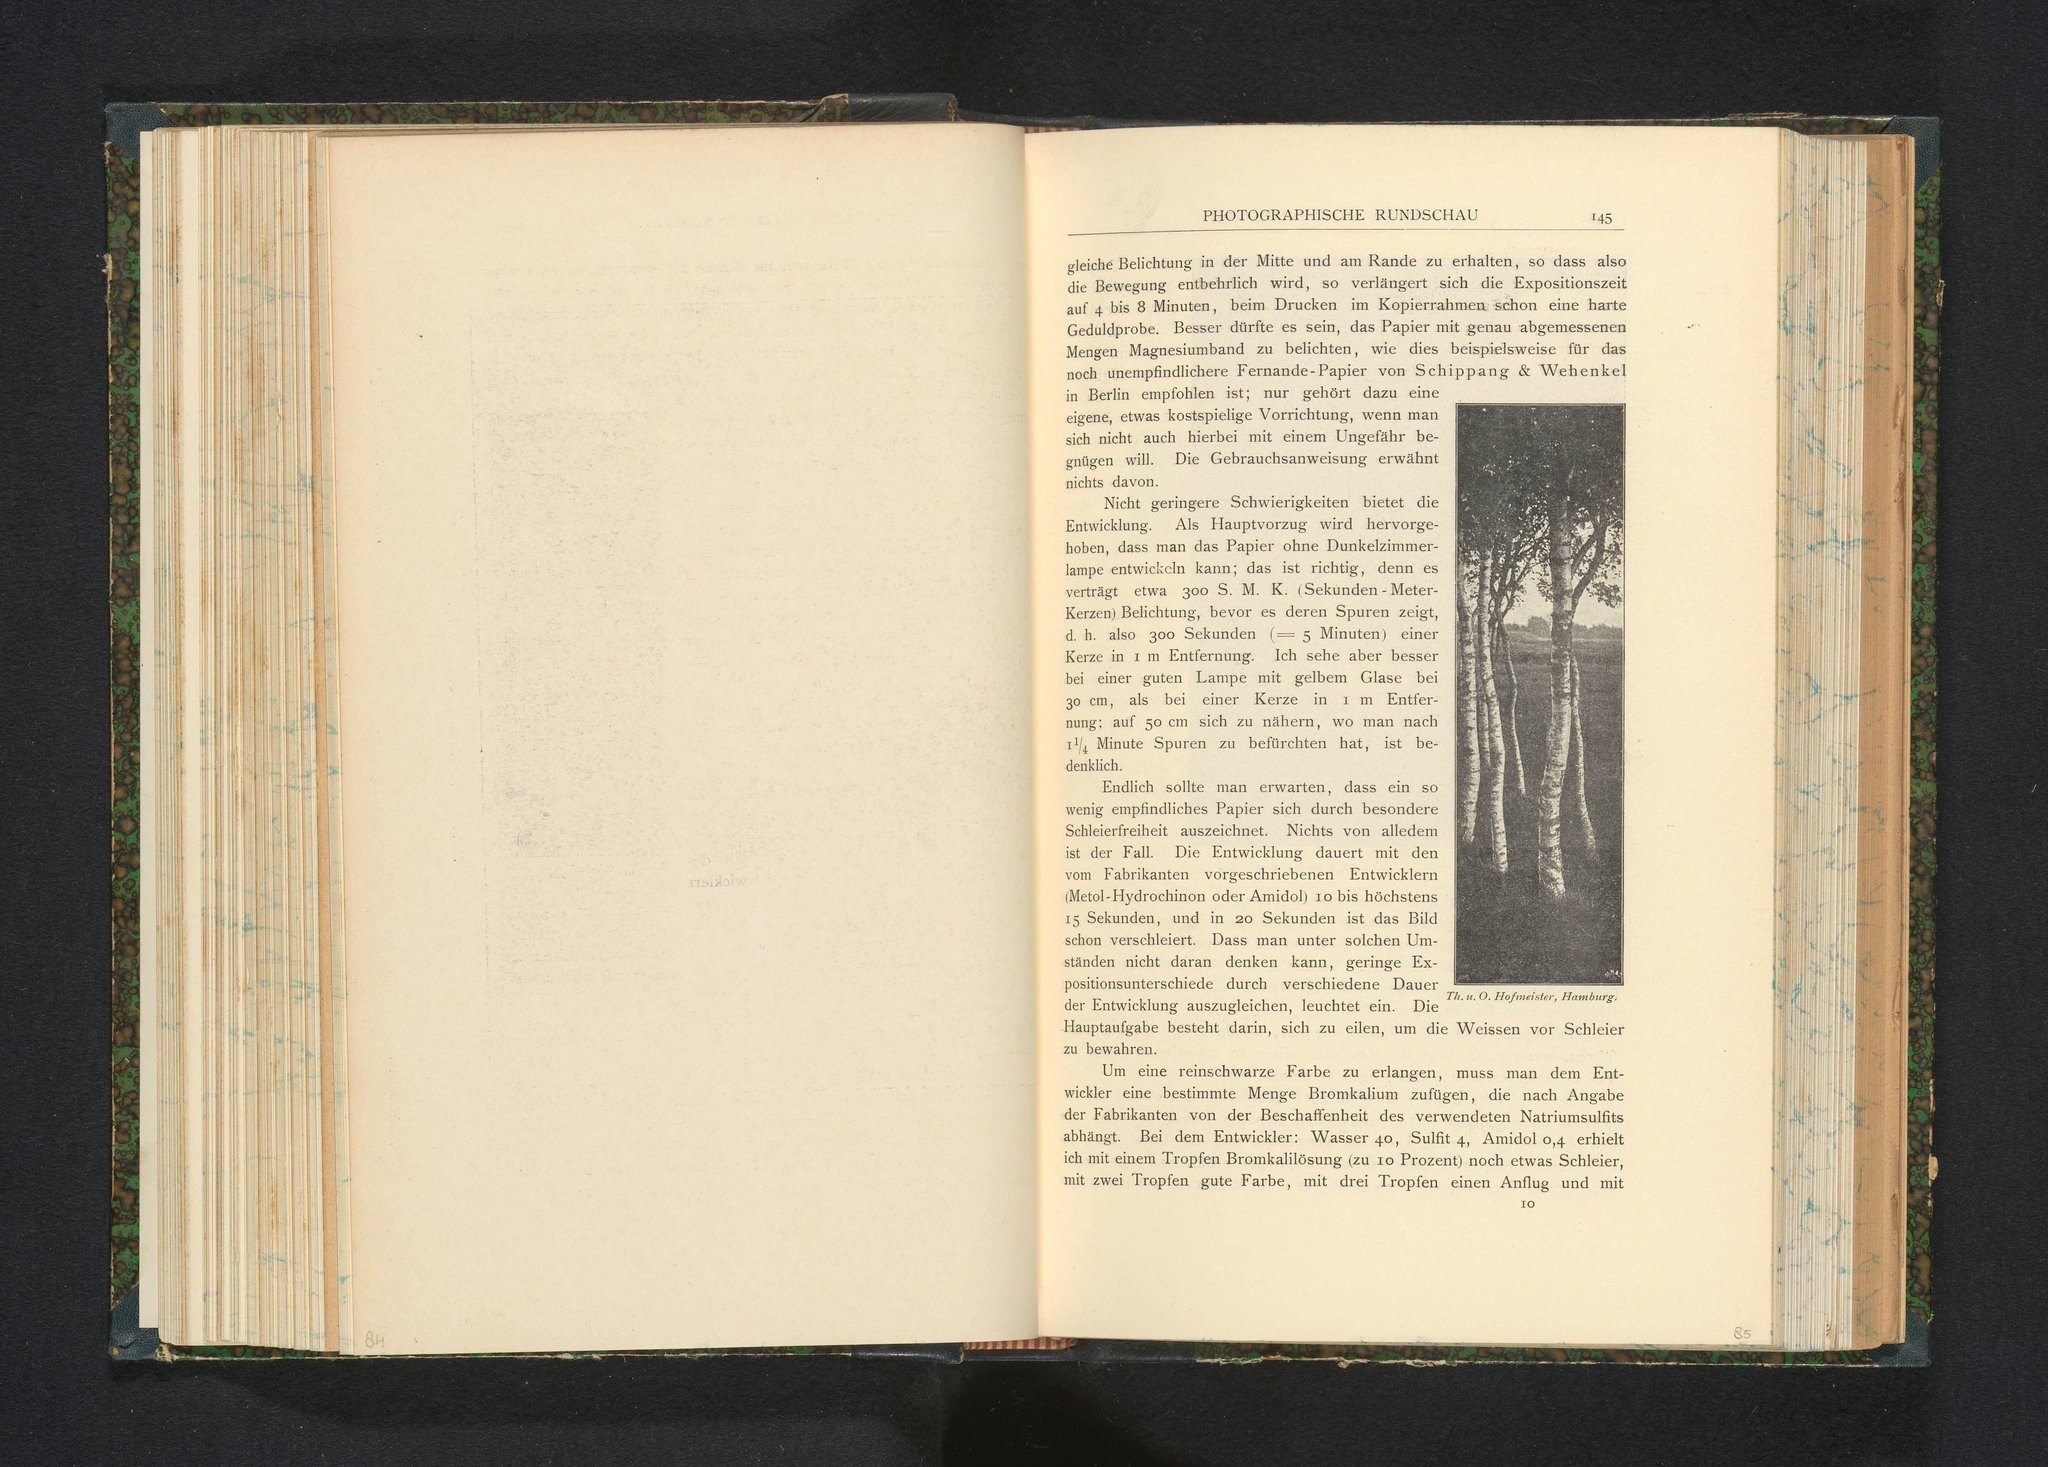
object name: page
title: Drietal dunne bomen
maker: th. u. o. hofmeister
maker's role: fotograaf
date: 1894-1899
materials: paper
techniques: autotype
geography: berlin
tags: trees